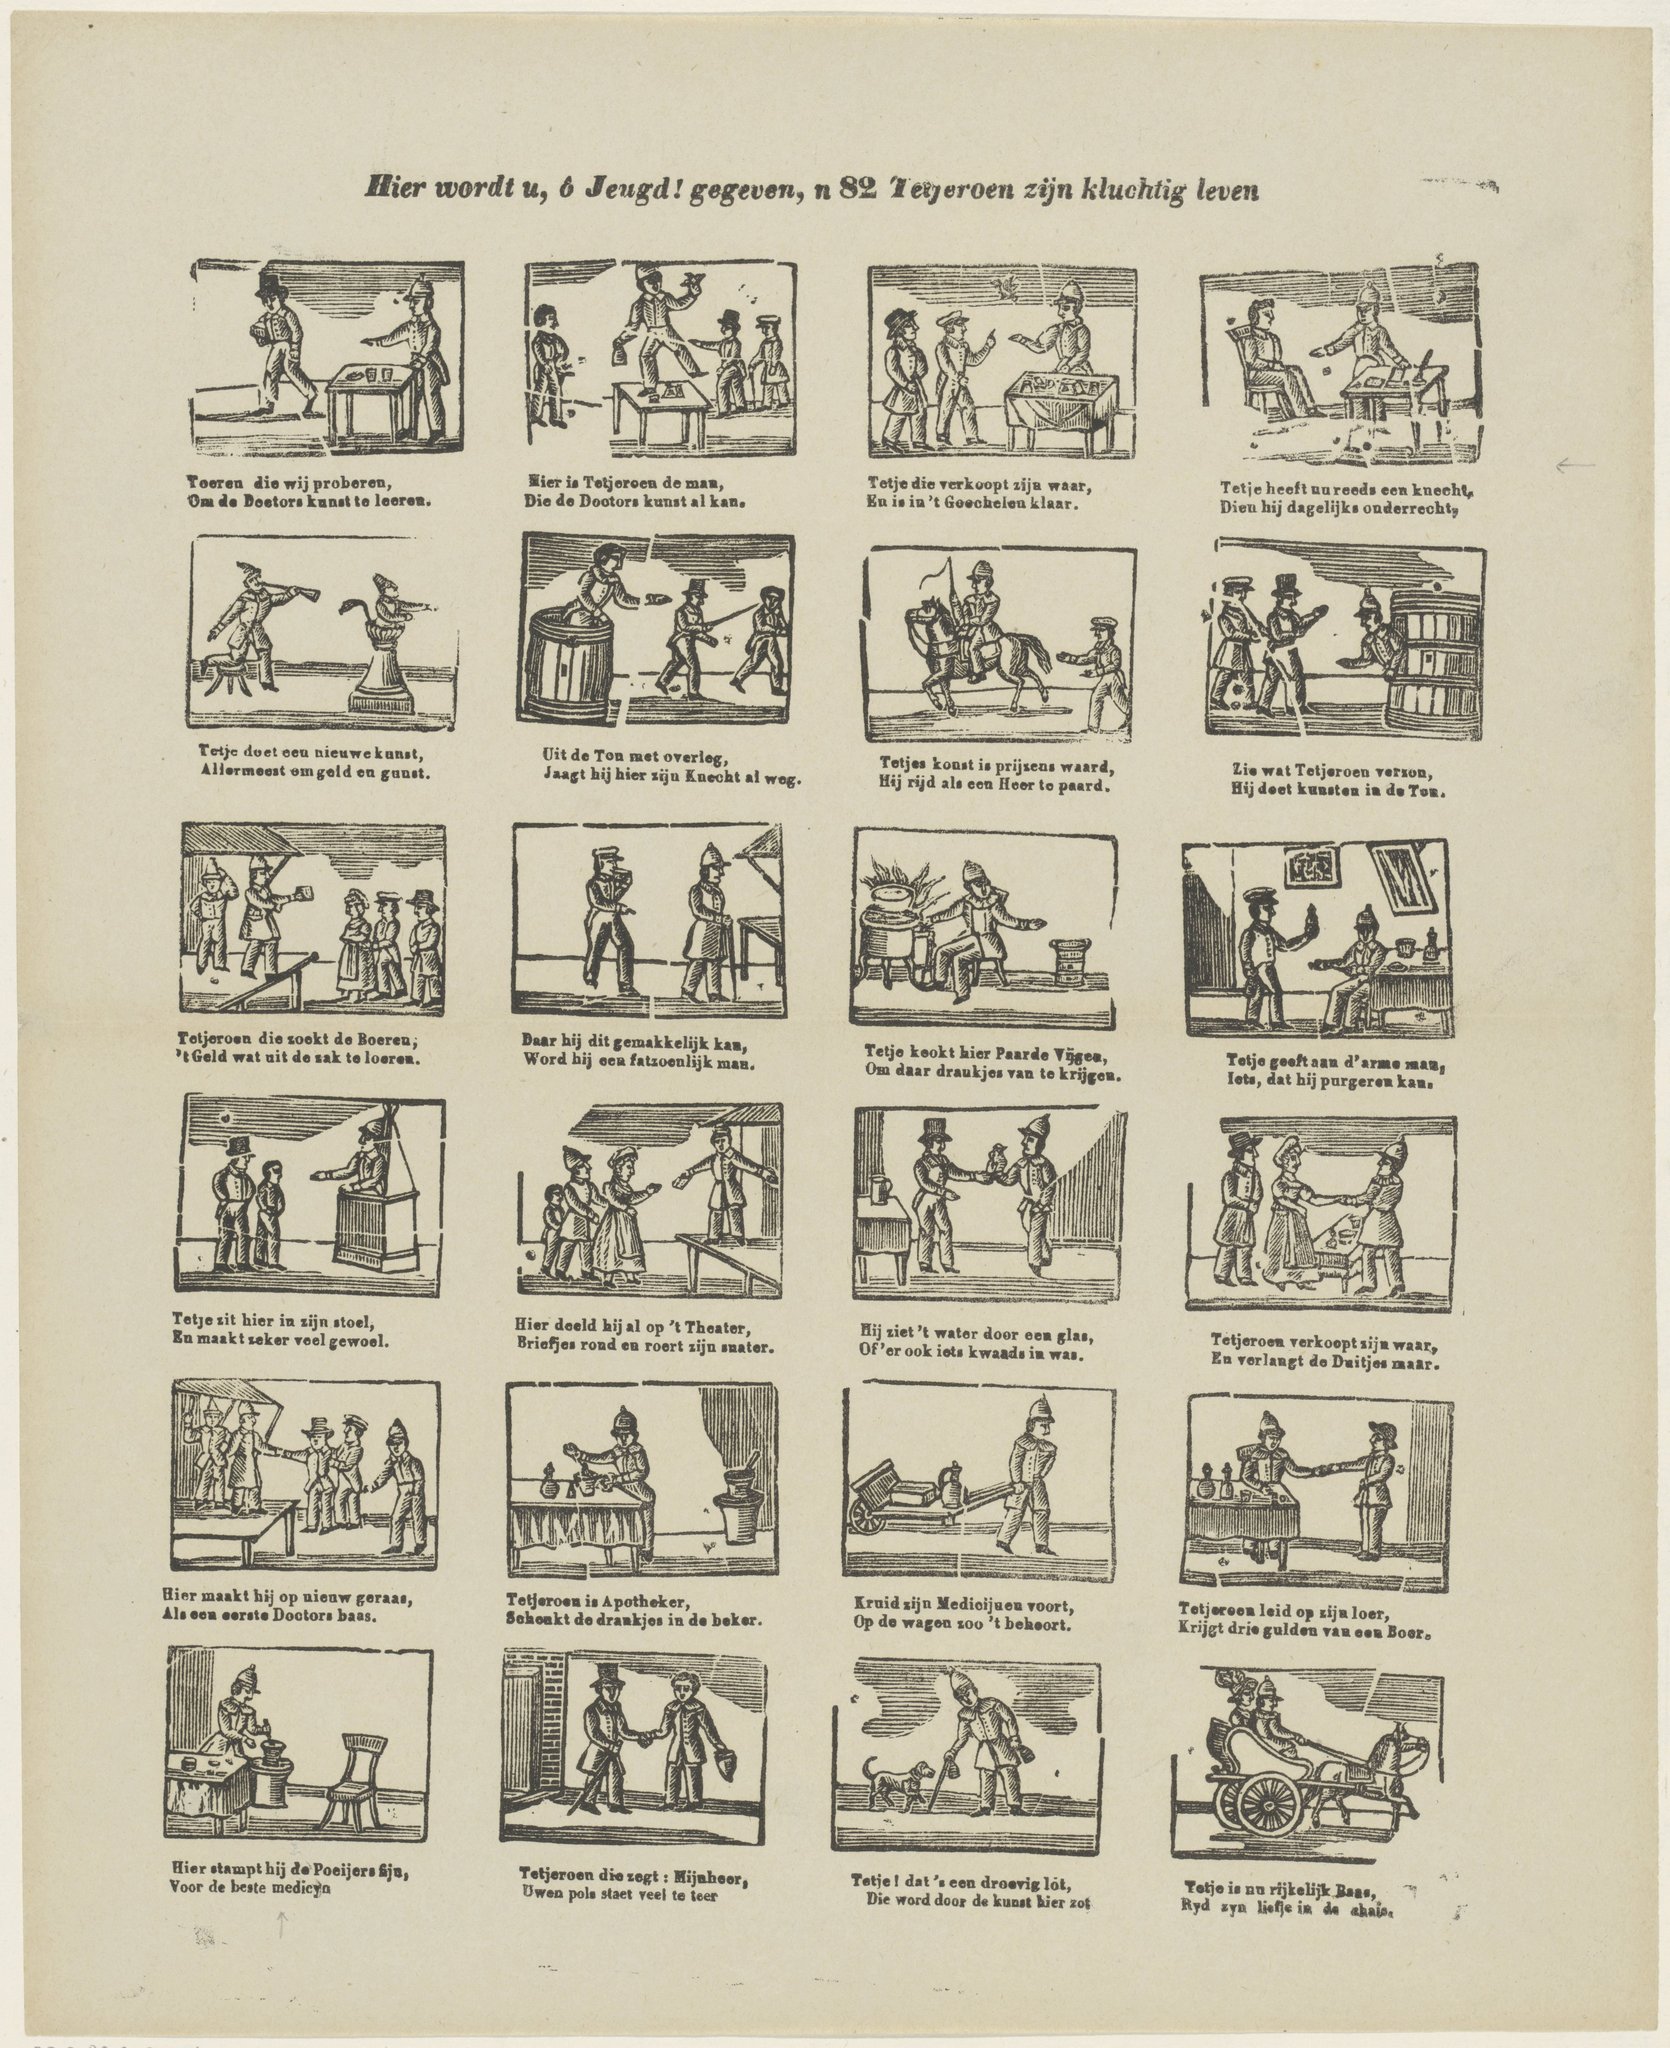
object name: print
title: Hier wordt u, ô jeugd! gegeven, / Tetjeroen zyn kluchtig leven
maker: Anonymous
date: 1856-1900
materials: paper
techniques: letterpress printing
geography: netherlands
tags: quack, charlatan, mountebank, 'saltimbanco', tales and fairy tales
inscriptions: collector's mark: Lugt 2760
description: Blad met 24 voorstellingen over het leven van de kwakzalver en grappenmaker Tetjeroen. Onder elke afbeelding een tweeregelig vers. Genummerd midden boven: n. 82.